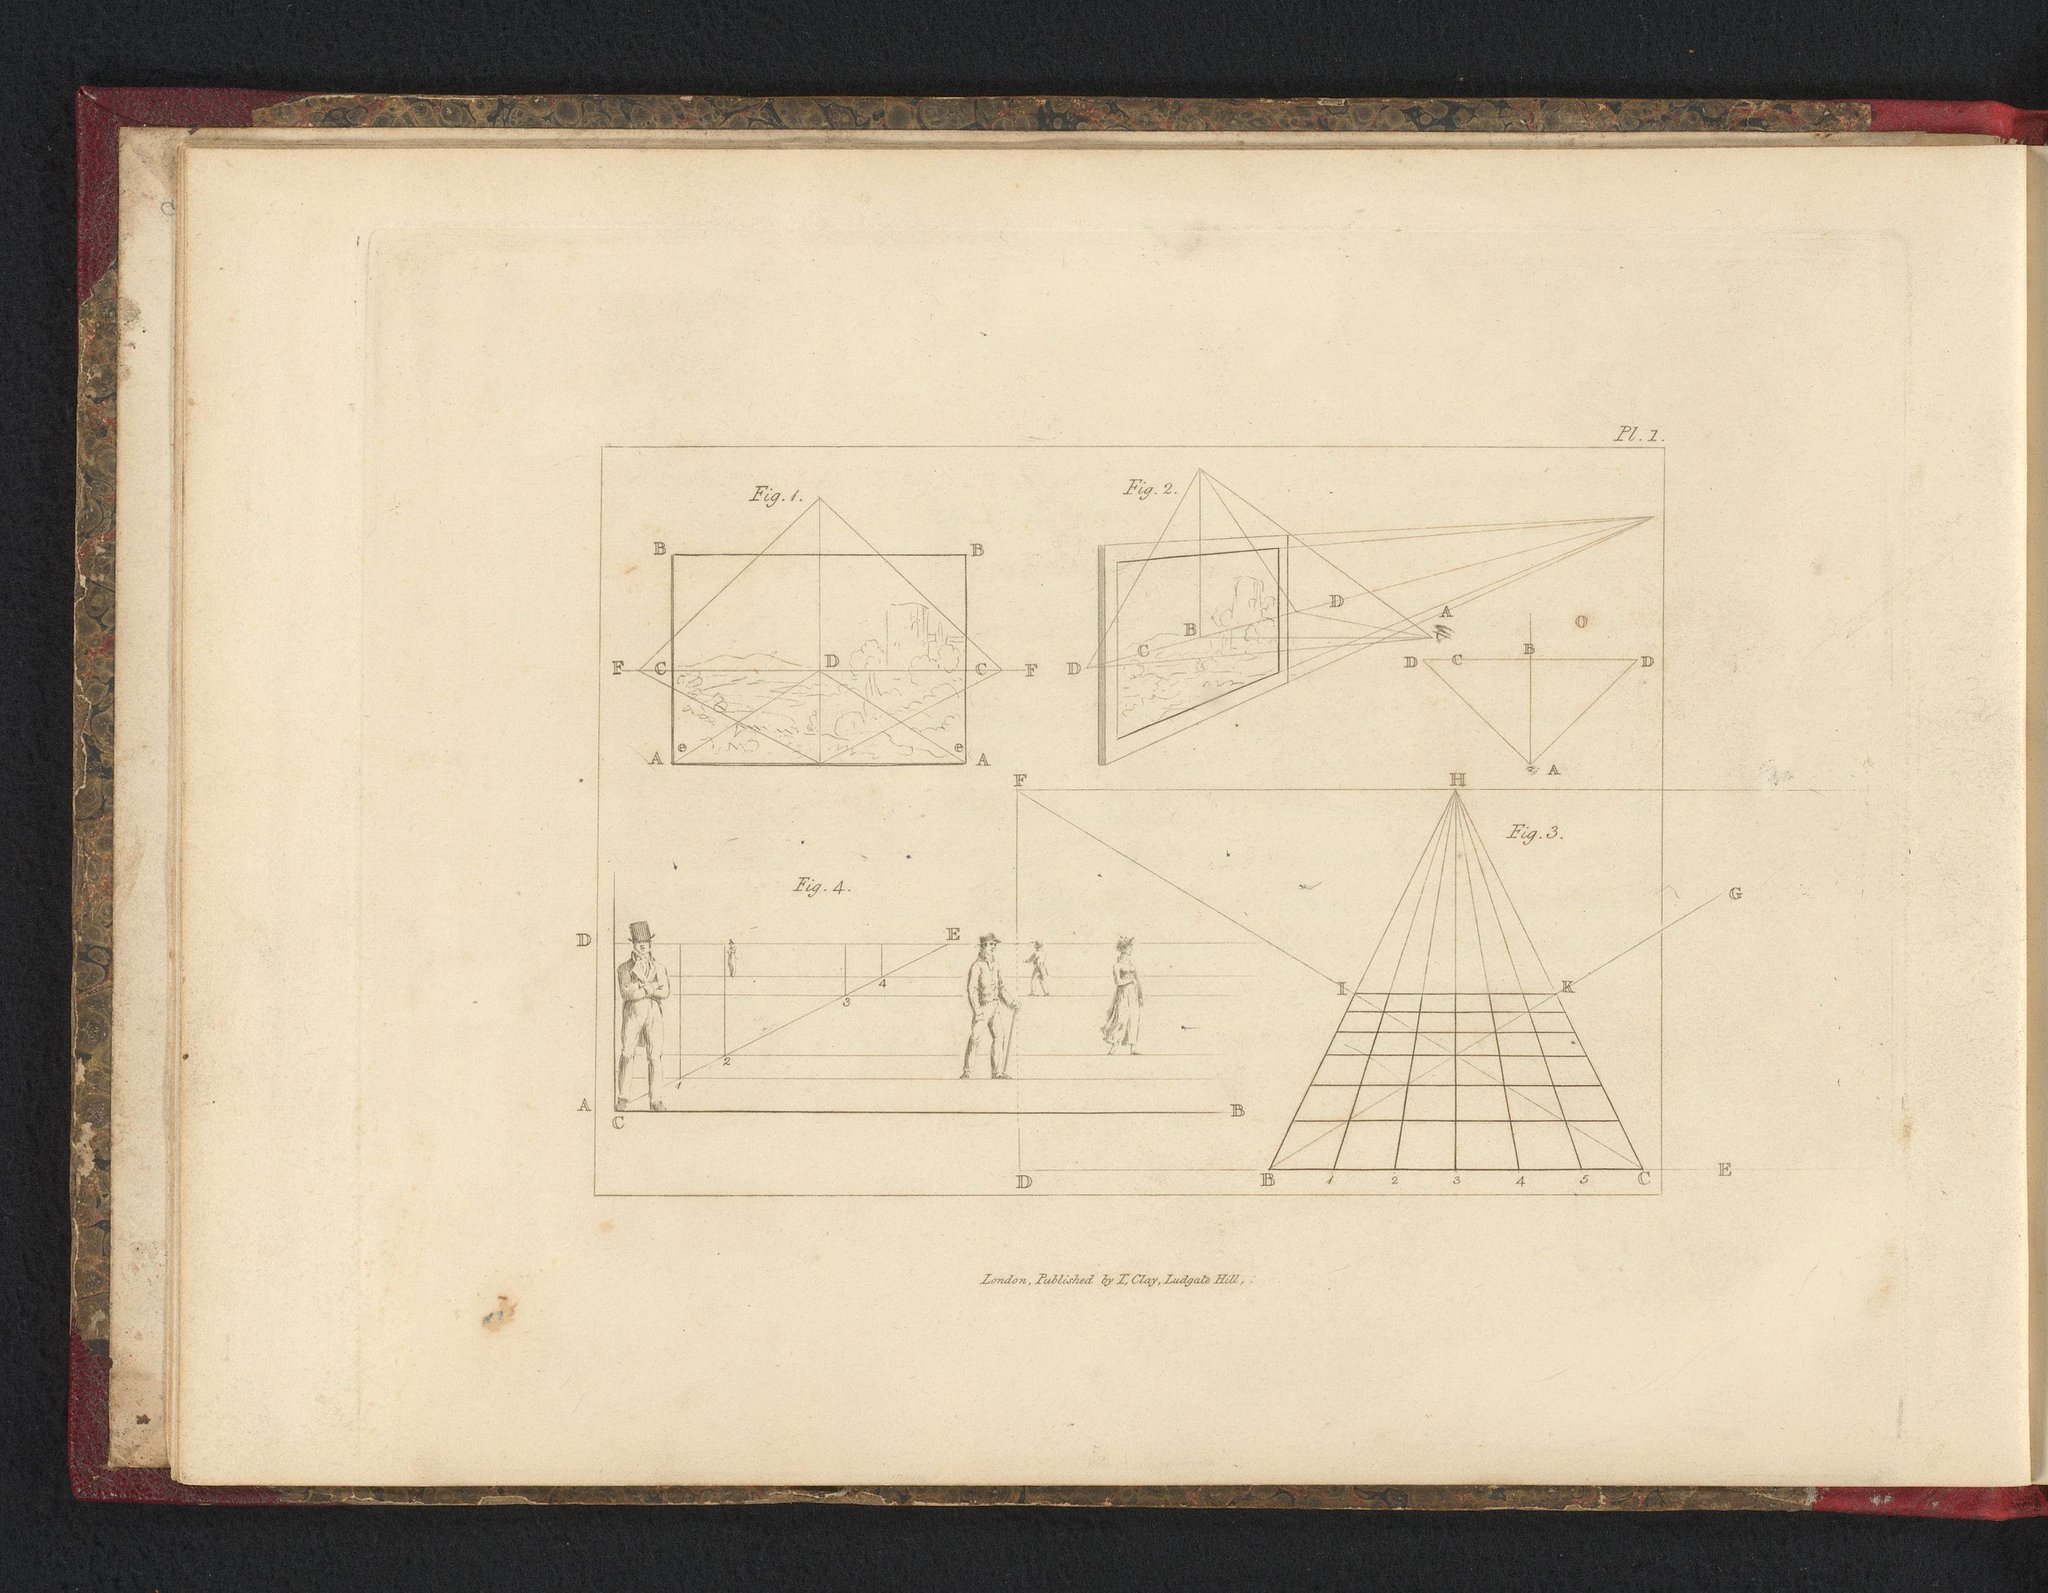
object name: print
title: Vier figuren waarop het perspectief van een kunstwerk gezien vanuit de beschouwer is weergegeven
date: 1828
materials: paper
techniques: engraving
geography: london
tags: painting (including book-illumination, miniature-painting), 'perspective' (alleg.); 'prospetiva' (ripa)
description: Genummerd: Pl. 1. Prent maakt deel uit van een boek.